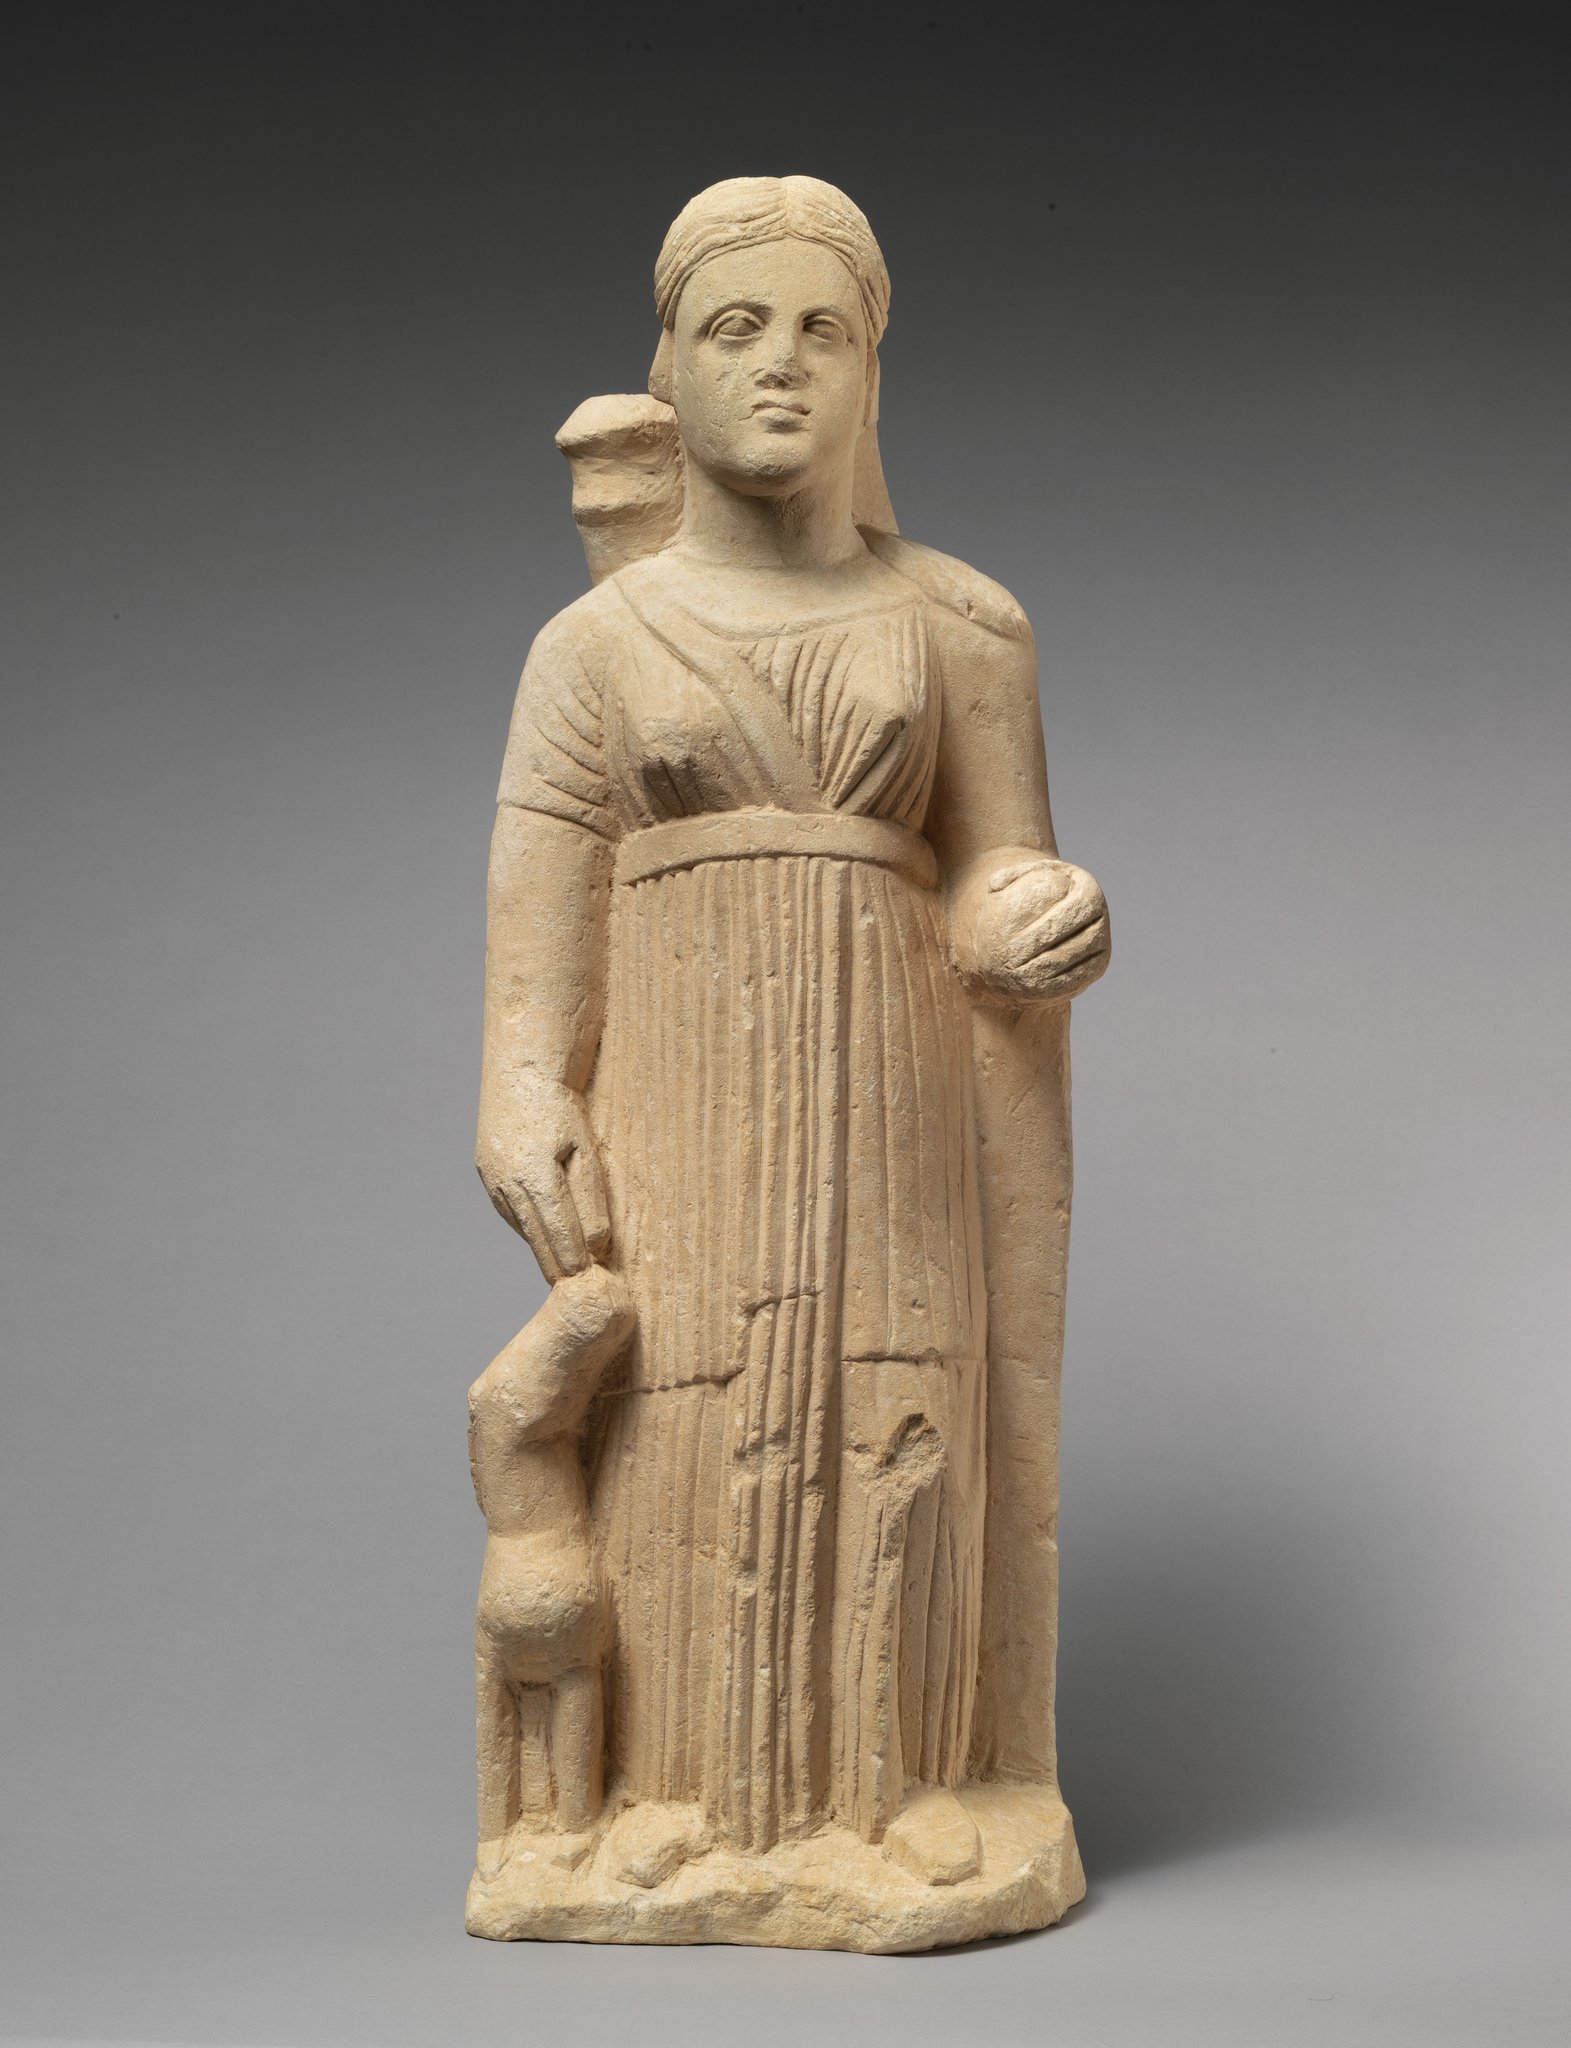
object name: statue of artemis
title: Limestone statue of the goddess Artemis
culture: cypriot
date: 300-201 BCE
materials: limestone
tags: artemis